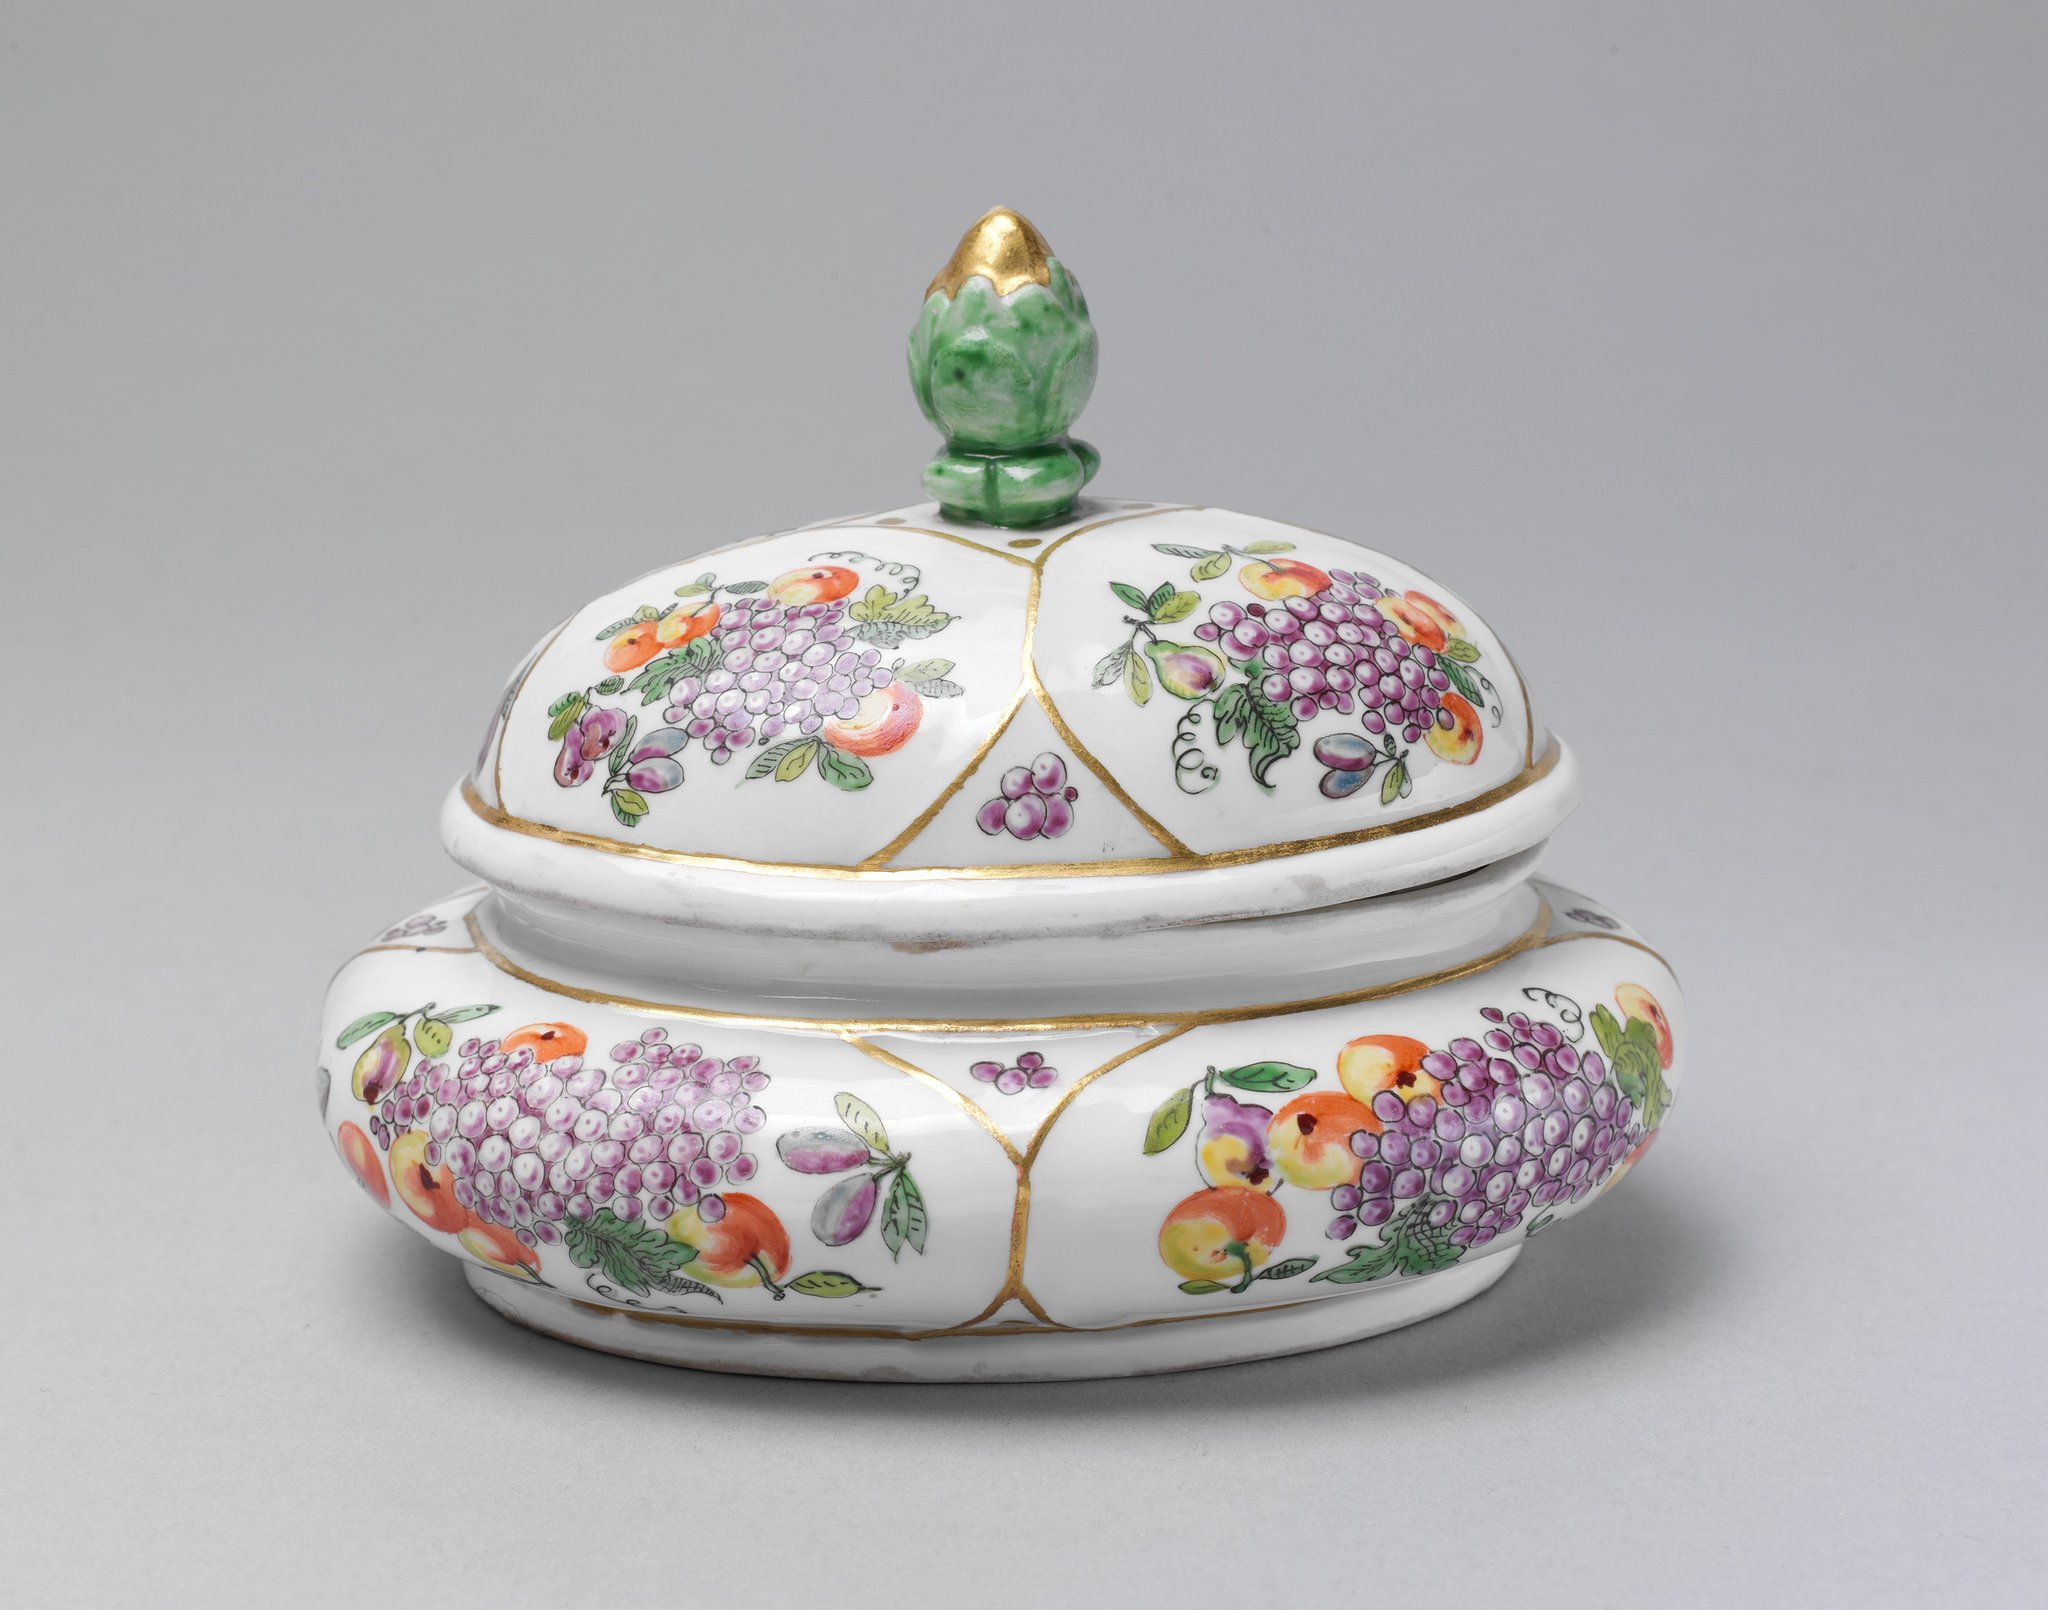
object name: sugar box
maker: vienna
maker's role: manufactory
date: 1730-1735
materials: hard paste porcelain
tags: apples,grapes